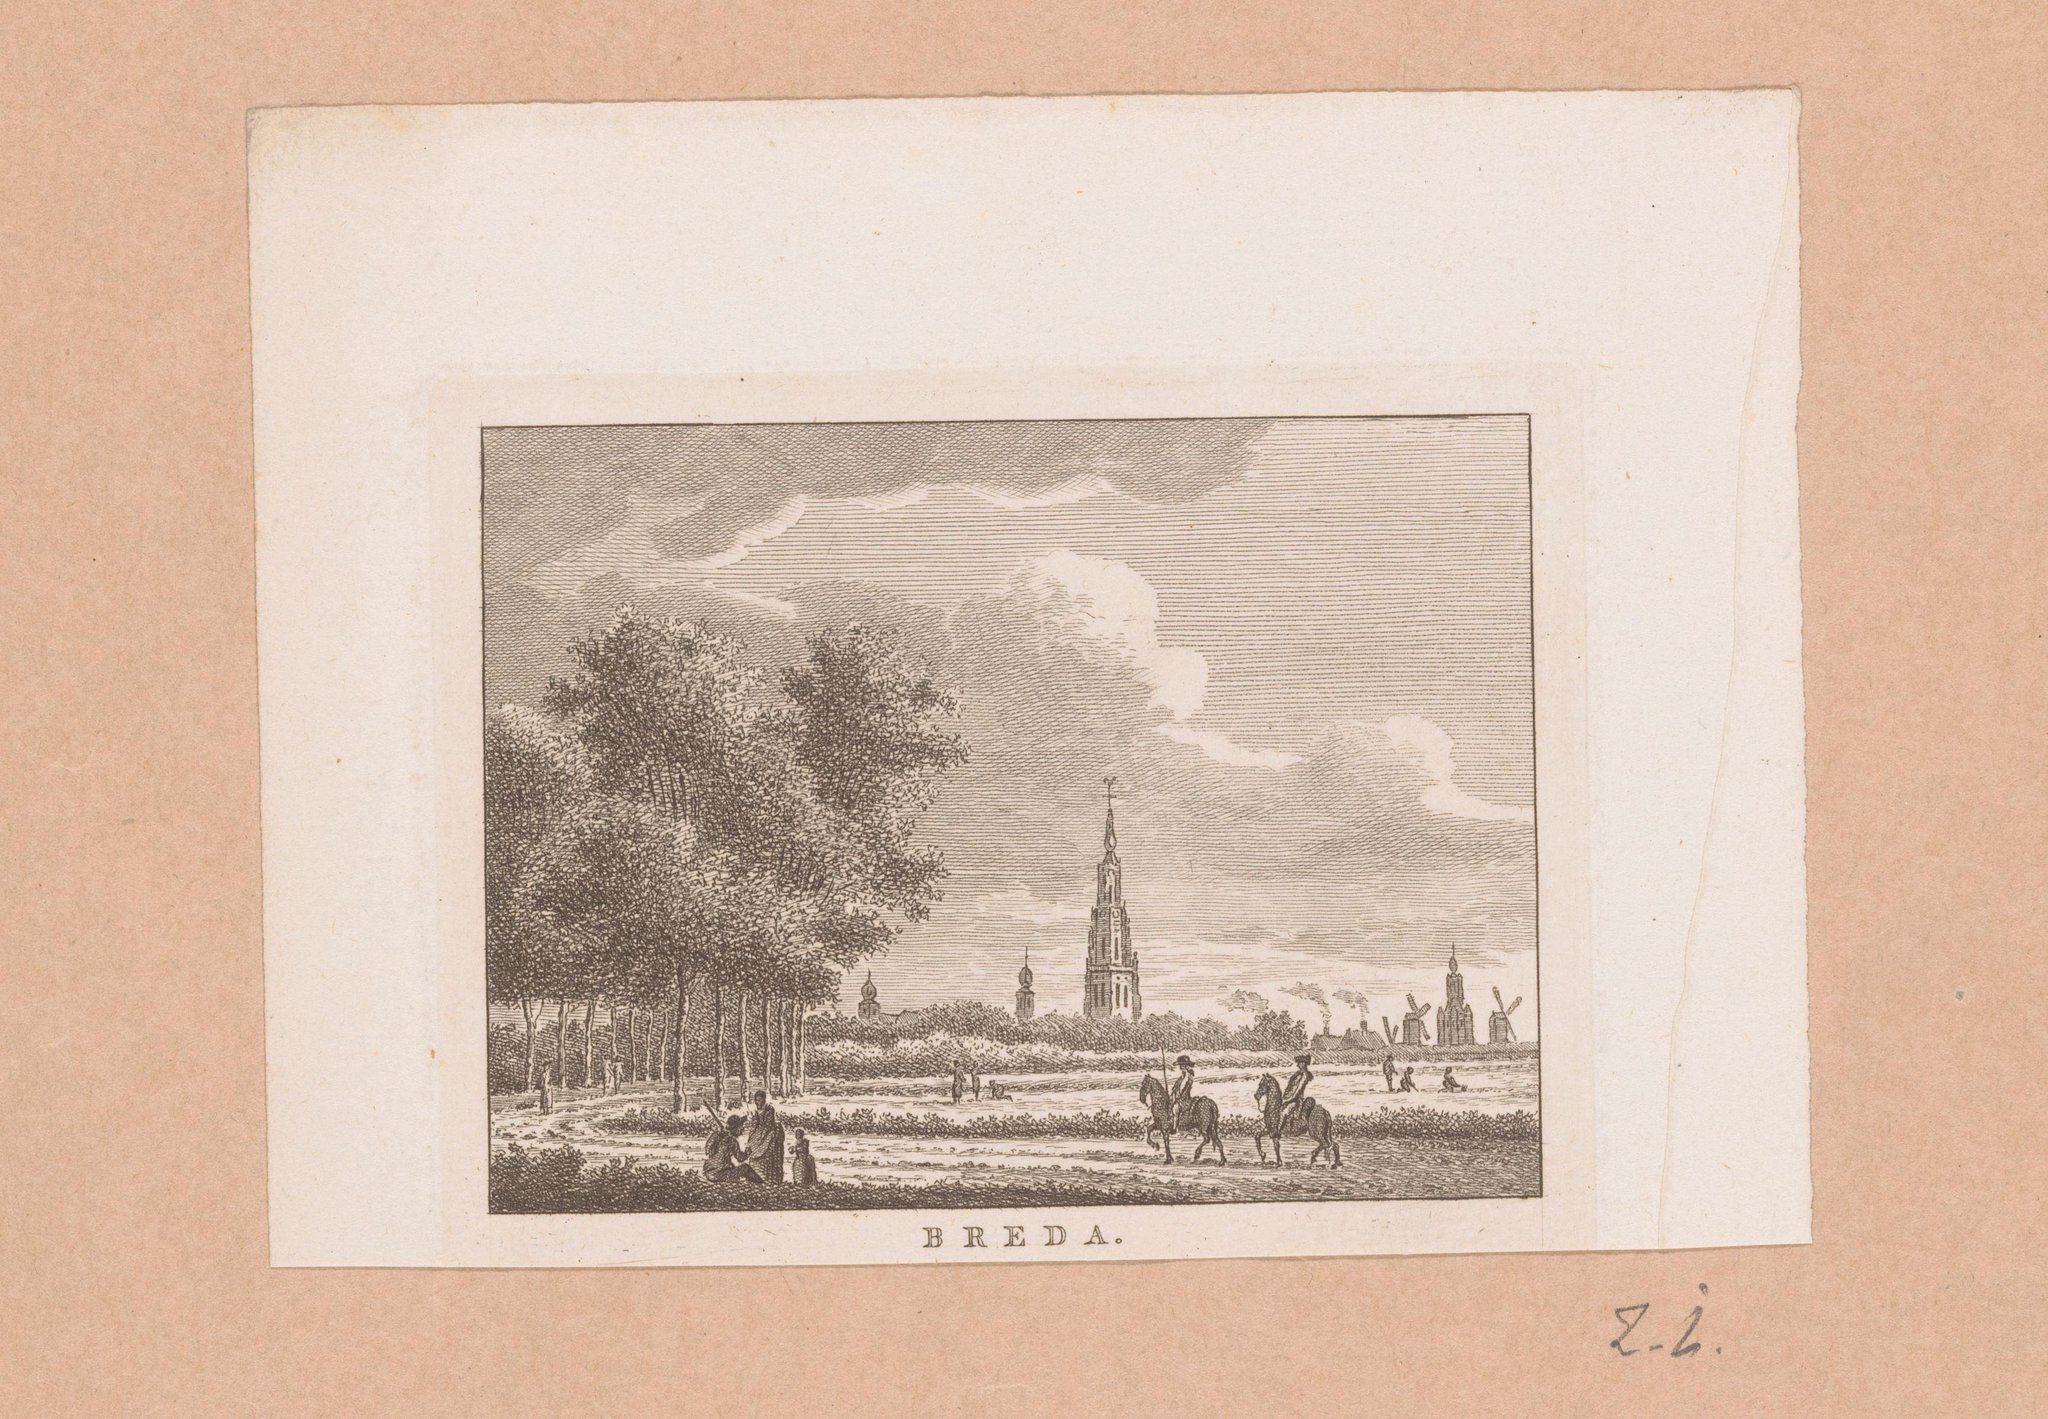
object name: print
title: Gezicht op Breda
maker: carel frederik bendorp (i)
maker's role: print maker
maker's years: 1736-1814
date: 1786-1792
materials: paper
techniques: engraving, etching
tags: church (exterior), prospect of city, town panorama, silhouette of city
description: Prent uit: Vaderlandsche gezichten, of afbeeldingen van den tegenwoordigen staat der Vereenigde Nederlanden (…). Amsterdam: Hendrik Gartman, Willem Vermandel en Jan Willem Smit, 1786-1792. Uitgegeven in afleveringen met ieder een eigen bifolium en inhoudsopgave. Alle prenten in deze publicatie zijn gegraveerd door Carel Frederik Bendorp (I) en, in de meeste gevallen, gebaseerd op tekeningen van Jan Bulthuis.